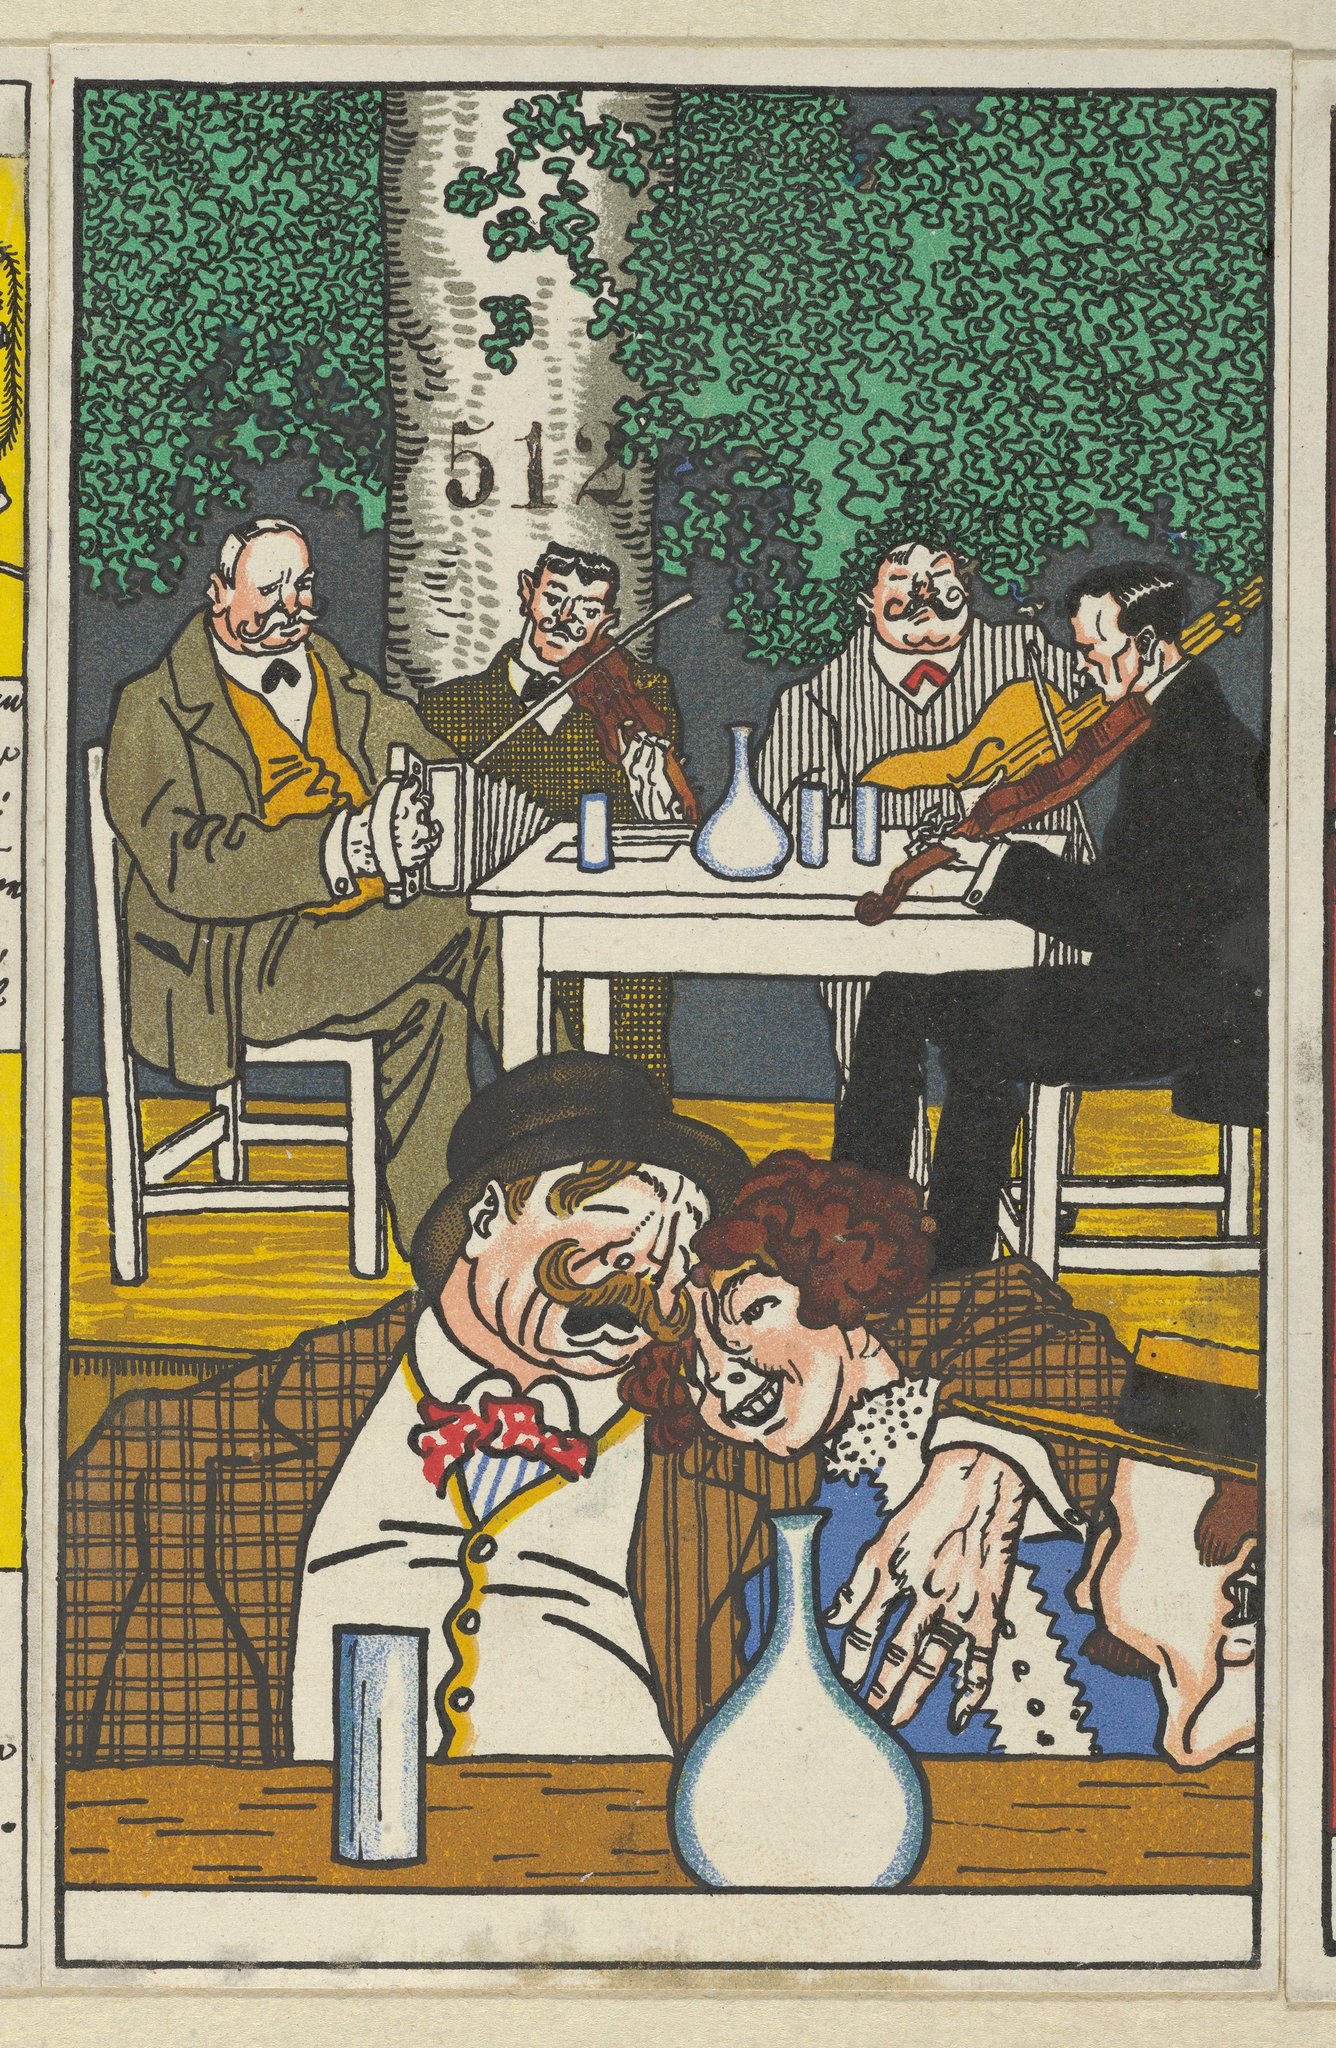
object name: print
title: At the Heuriger (Beim Heurigen)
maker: moriz jung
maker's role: artist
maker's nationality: austrian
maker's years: 1885-1915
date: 1911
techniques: lithograph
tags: satire,men,women,violins